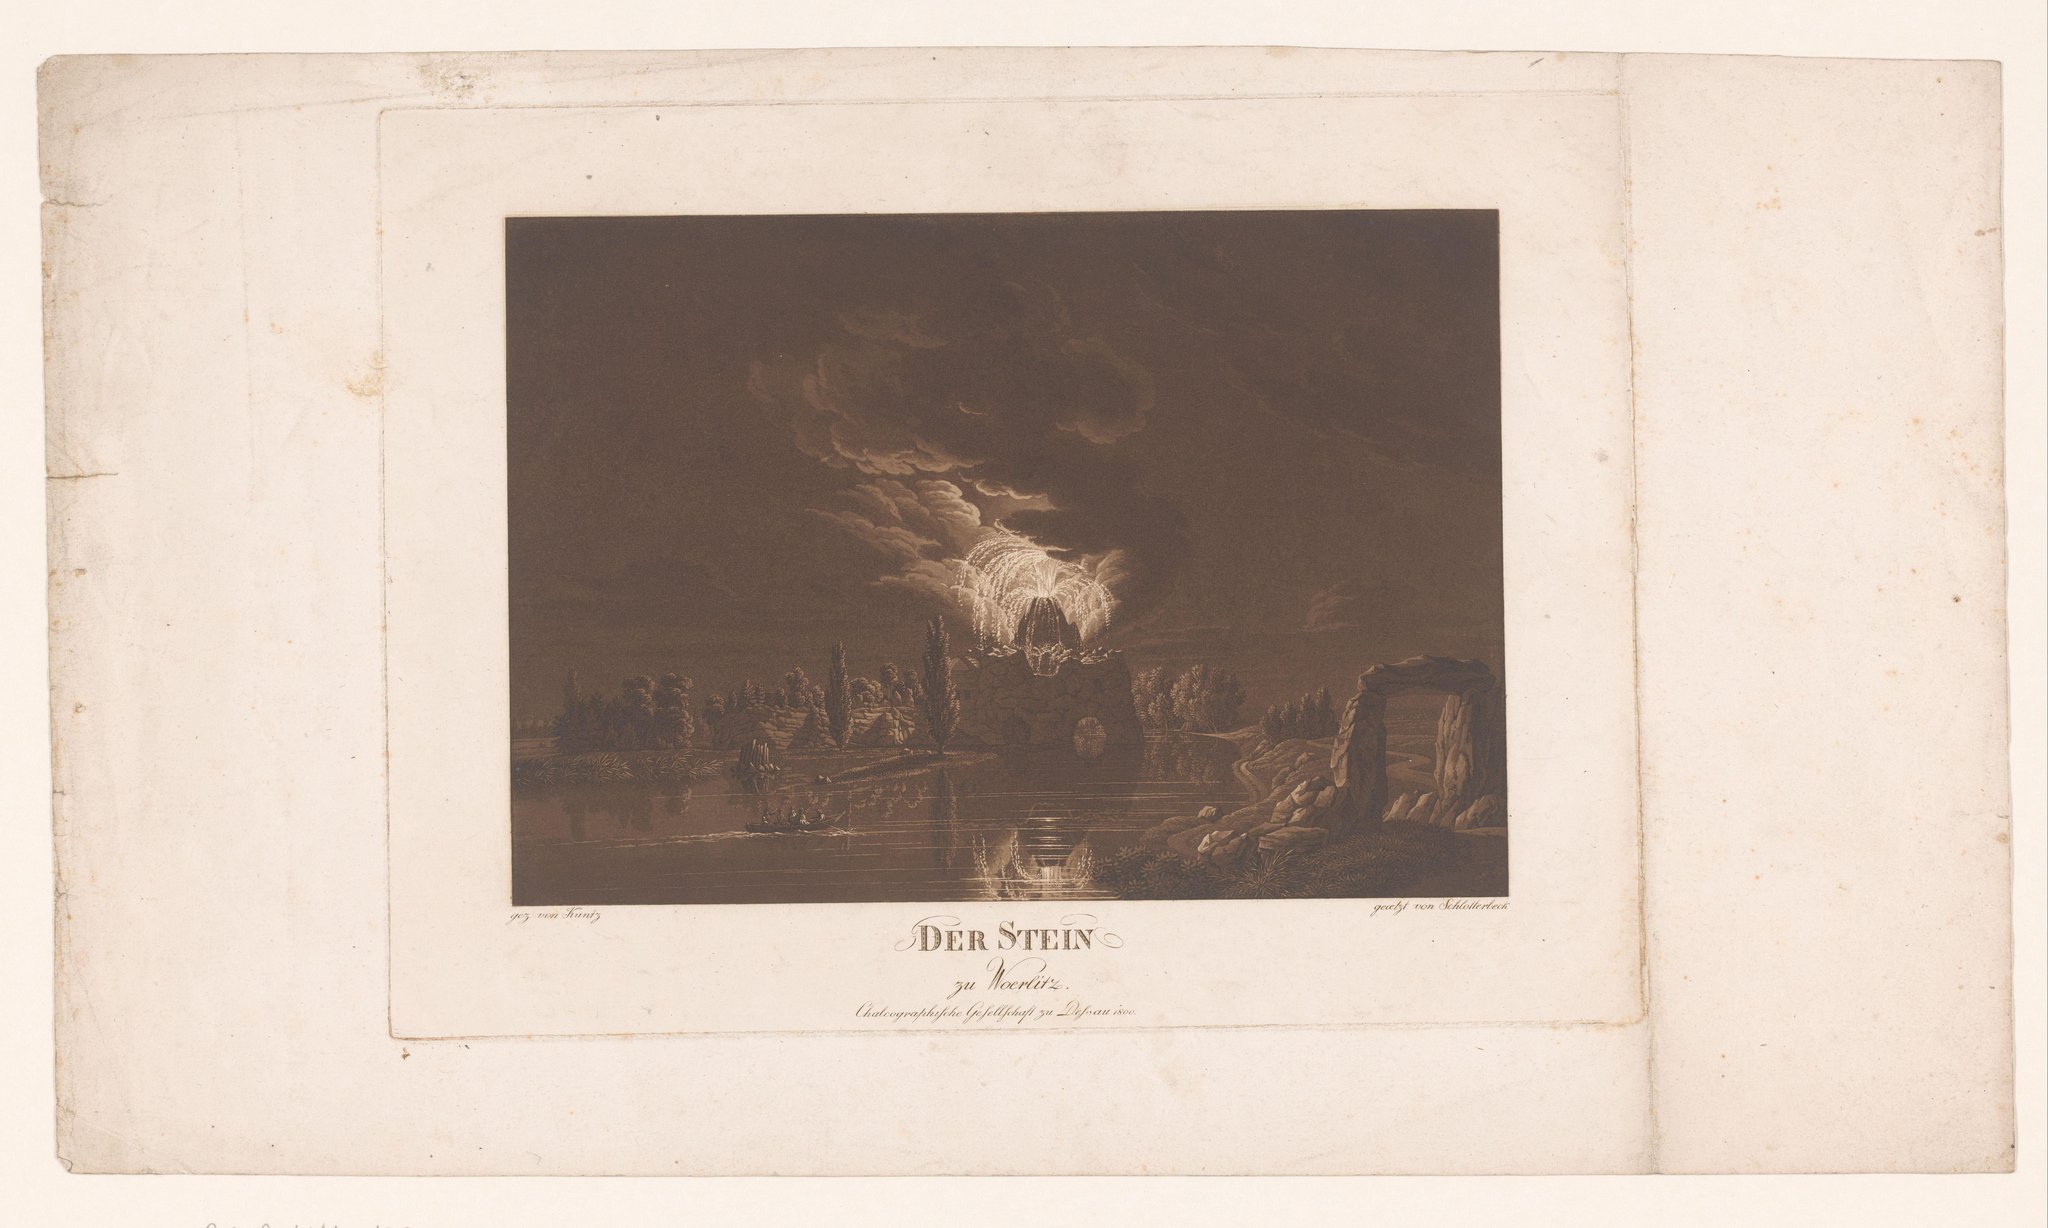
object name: print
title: Der Stein zu Woerlitz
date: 1800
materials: paper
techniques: aquatint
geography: dessau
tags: architectural folly, bonfire, fire-works - aa - festivities on the water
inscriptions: collector's mark: Lugt 2228